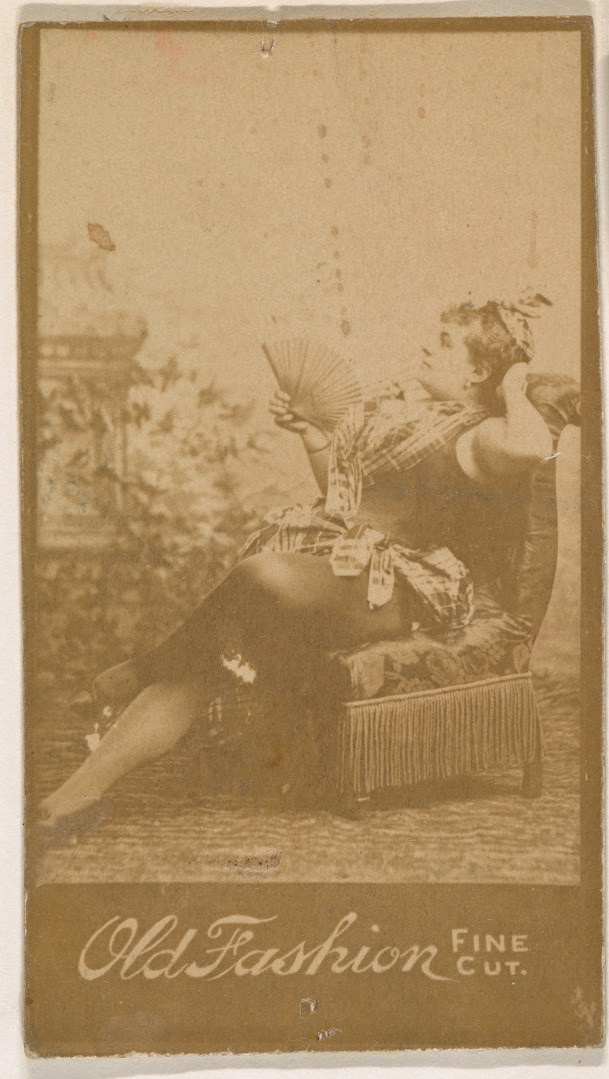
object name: photograph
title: Actress reclining on chair, from the Actresses series (N664) promoting Old Fashion Fine Cut Tobacco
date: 1888-1890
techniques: albumen silver print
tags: fans,portraits,women,actresses